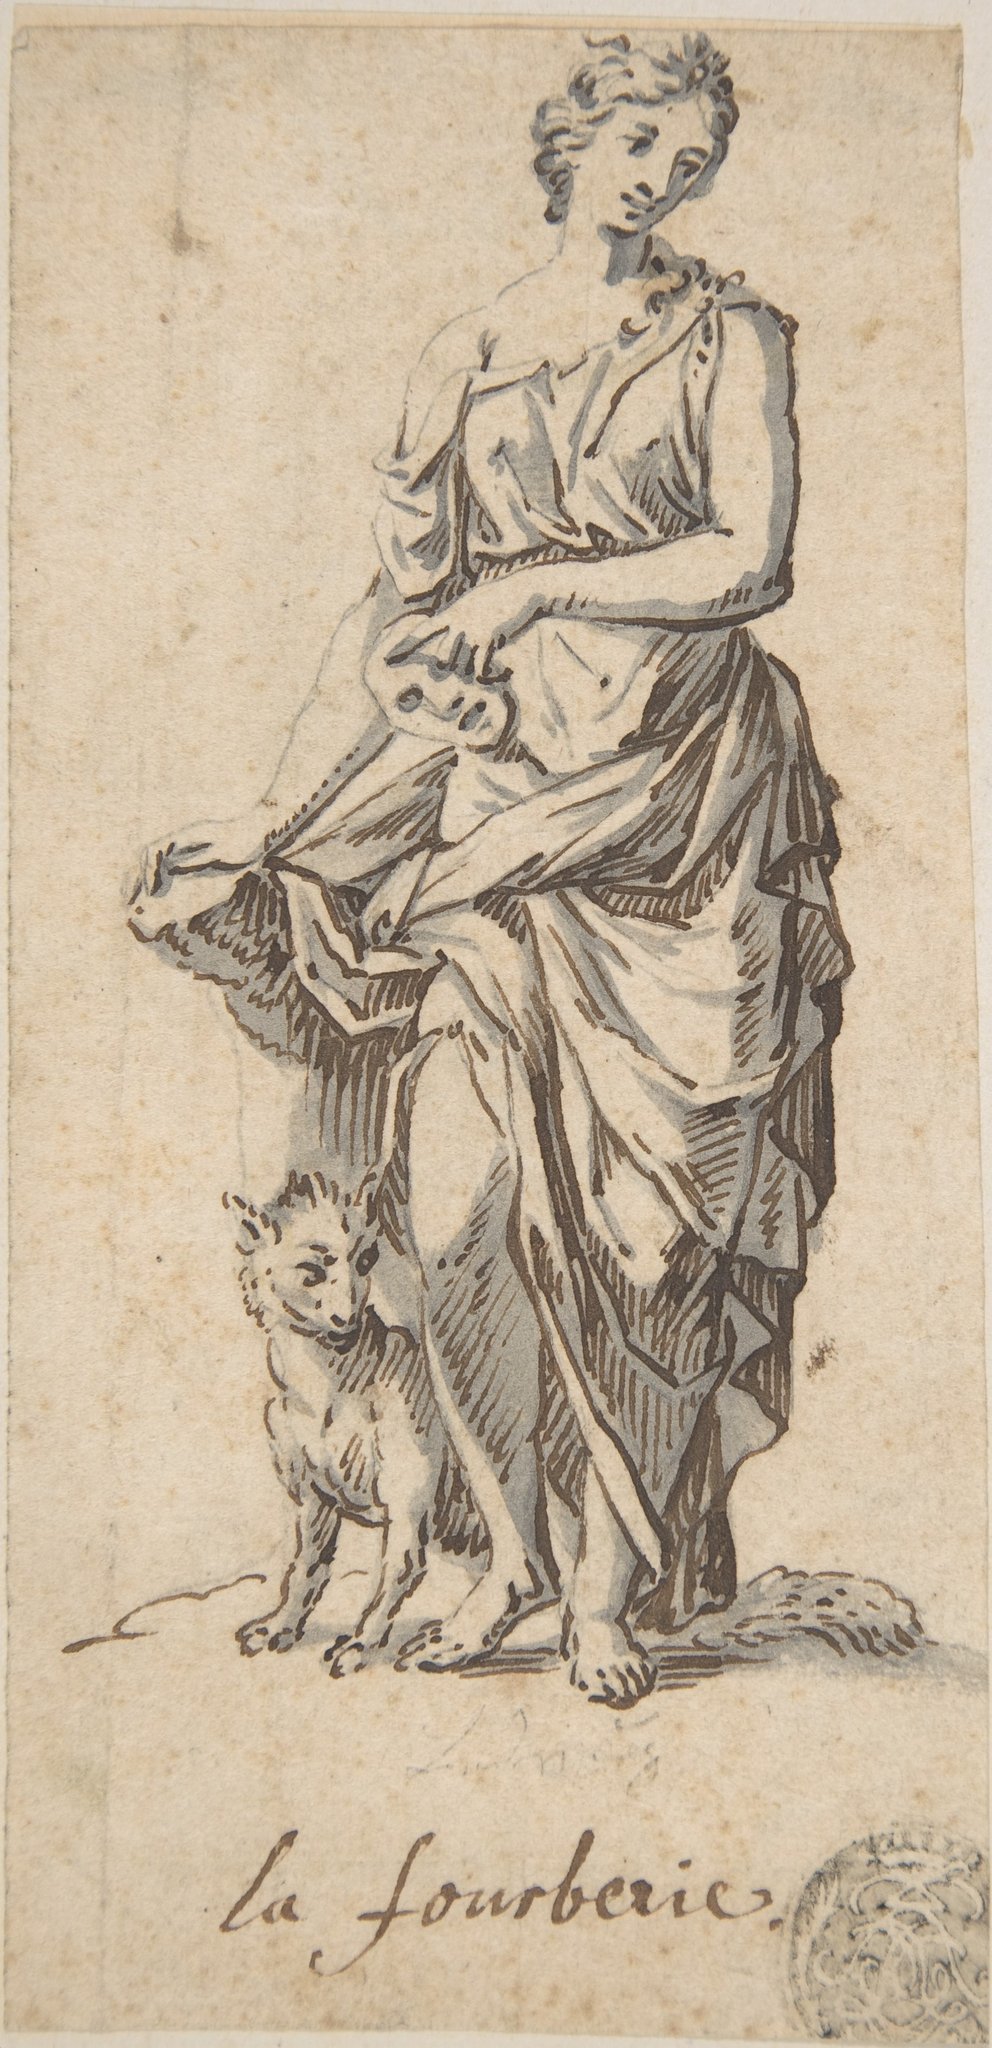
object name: drawing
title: La fourberie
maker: anonymous, french, 17th century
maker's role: artist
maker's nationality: french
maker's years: 1600-1700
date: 1601-1700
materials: graphite, ink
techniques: brush, pen, wash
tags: animals,women